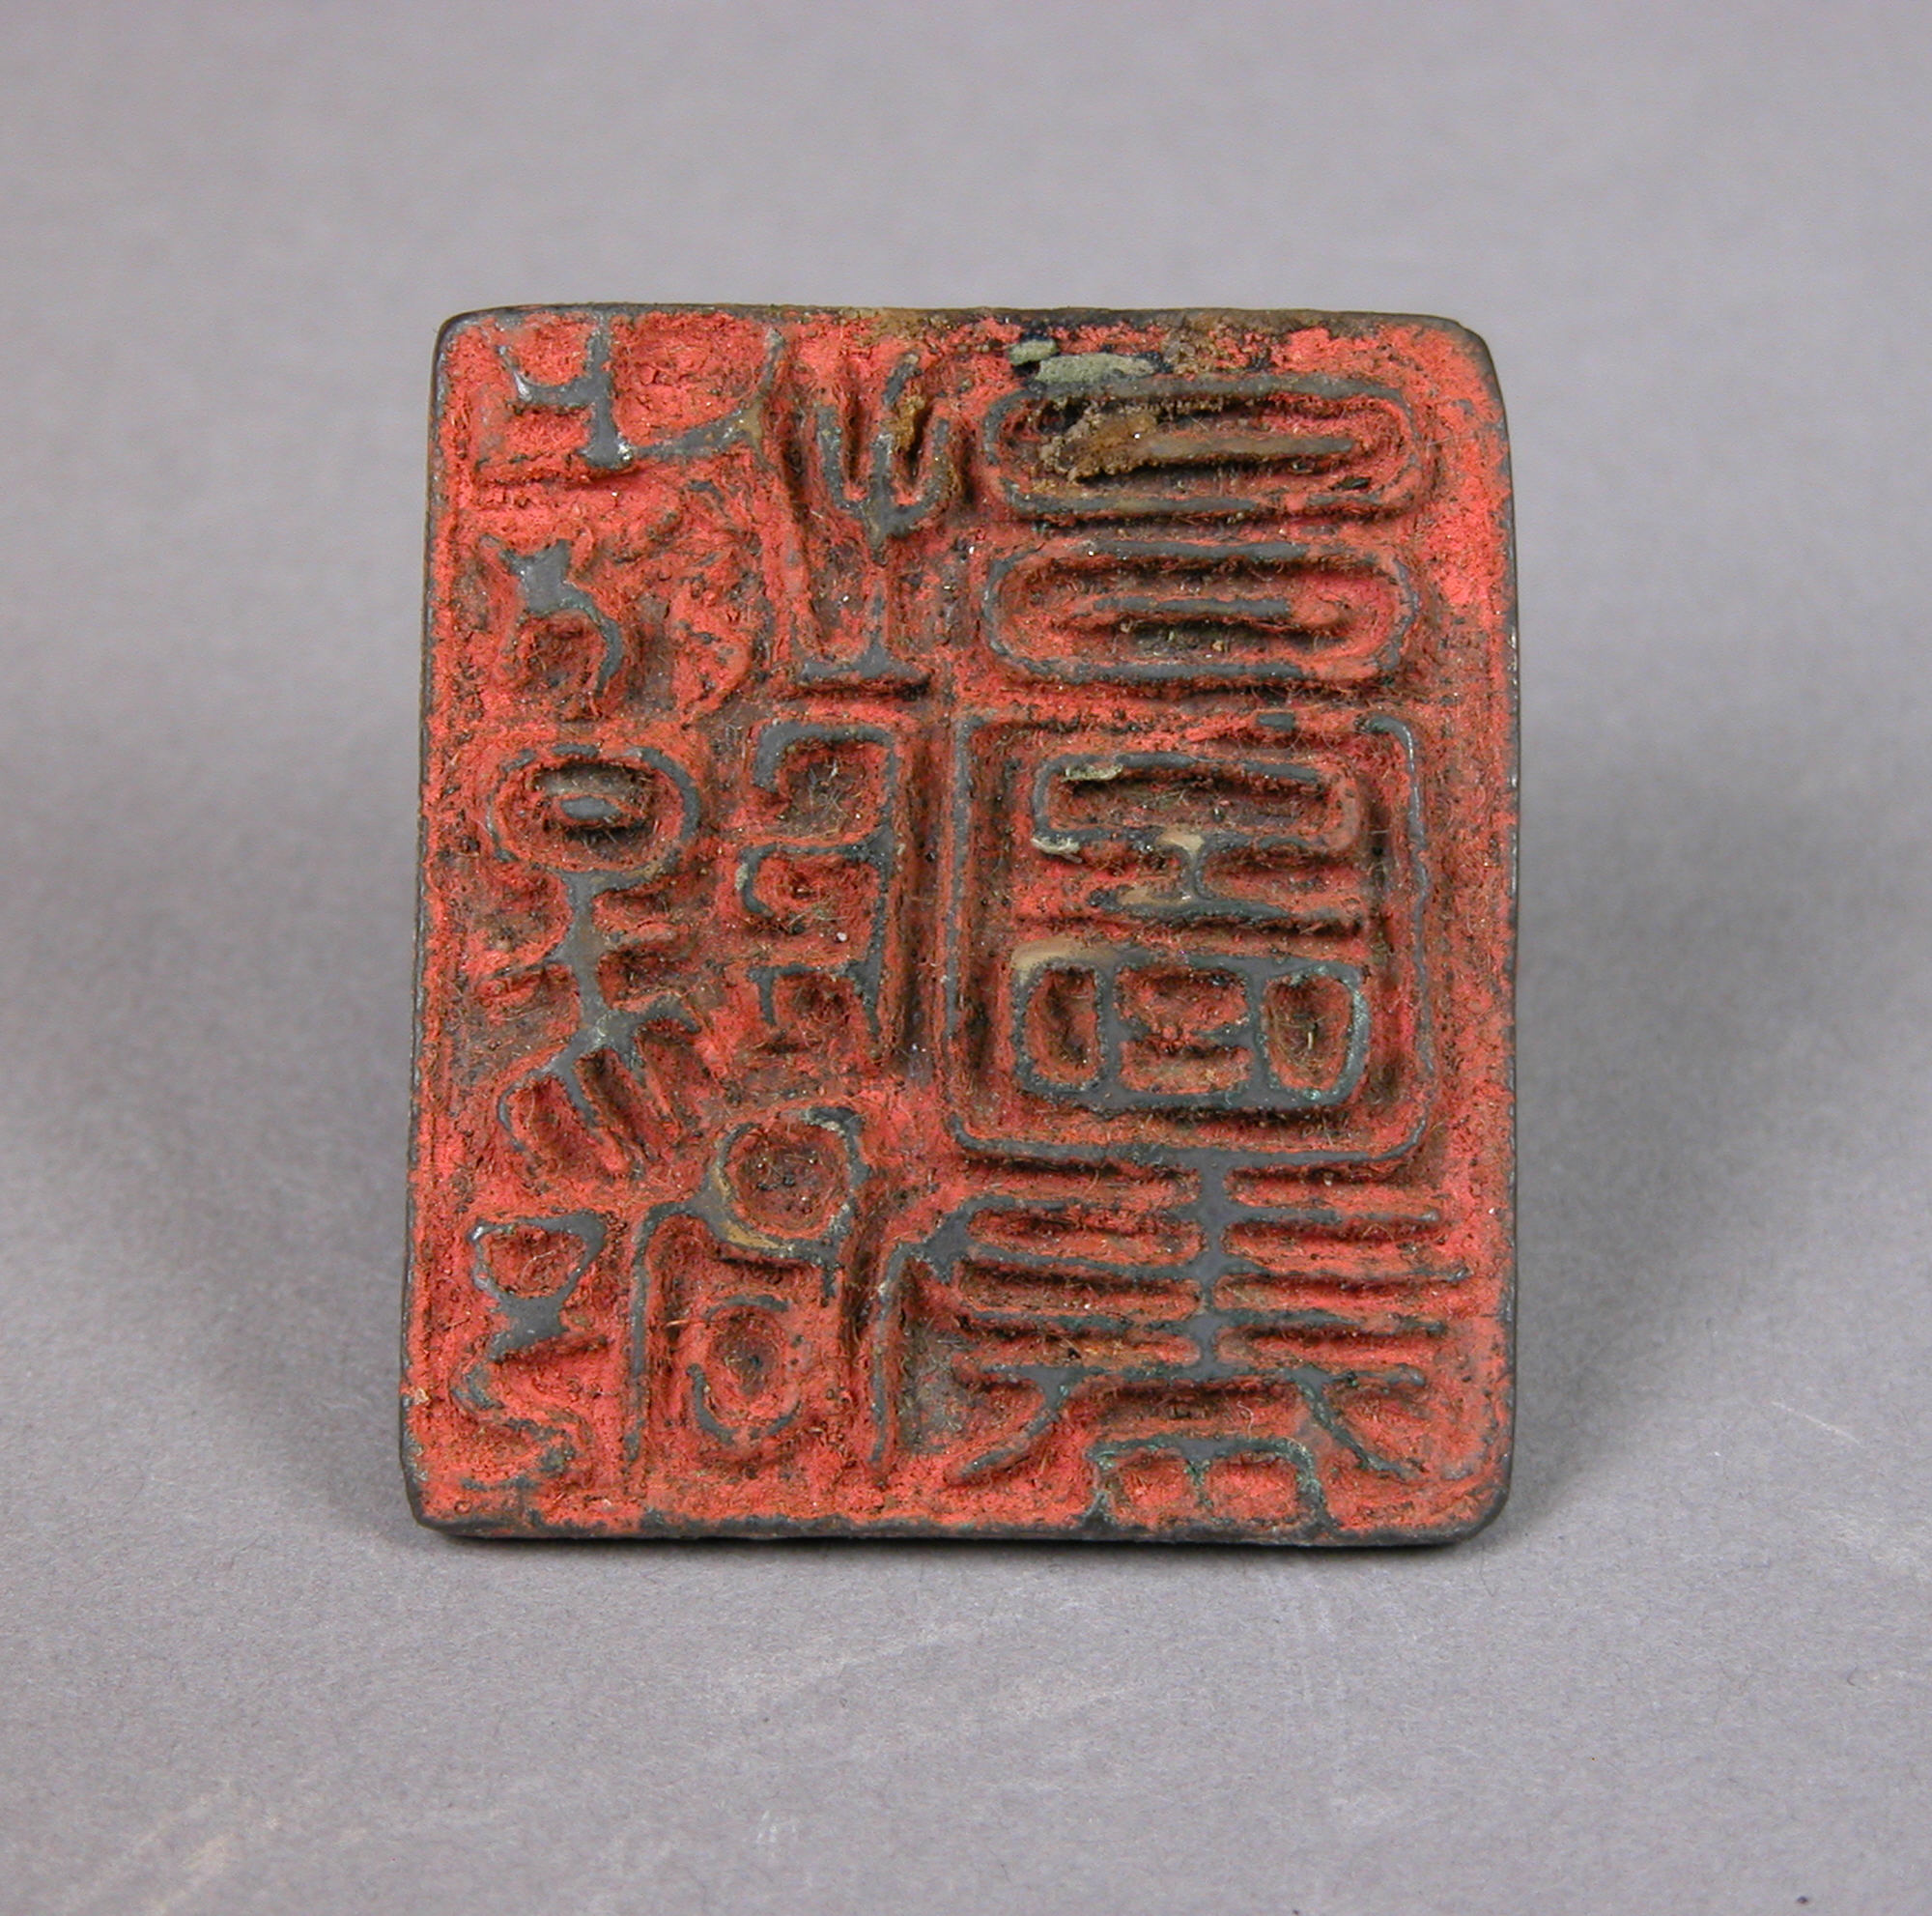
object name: seal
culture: chinese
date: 1300-1644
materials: bronze